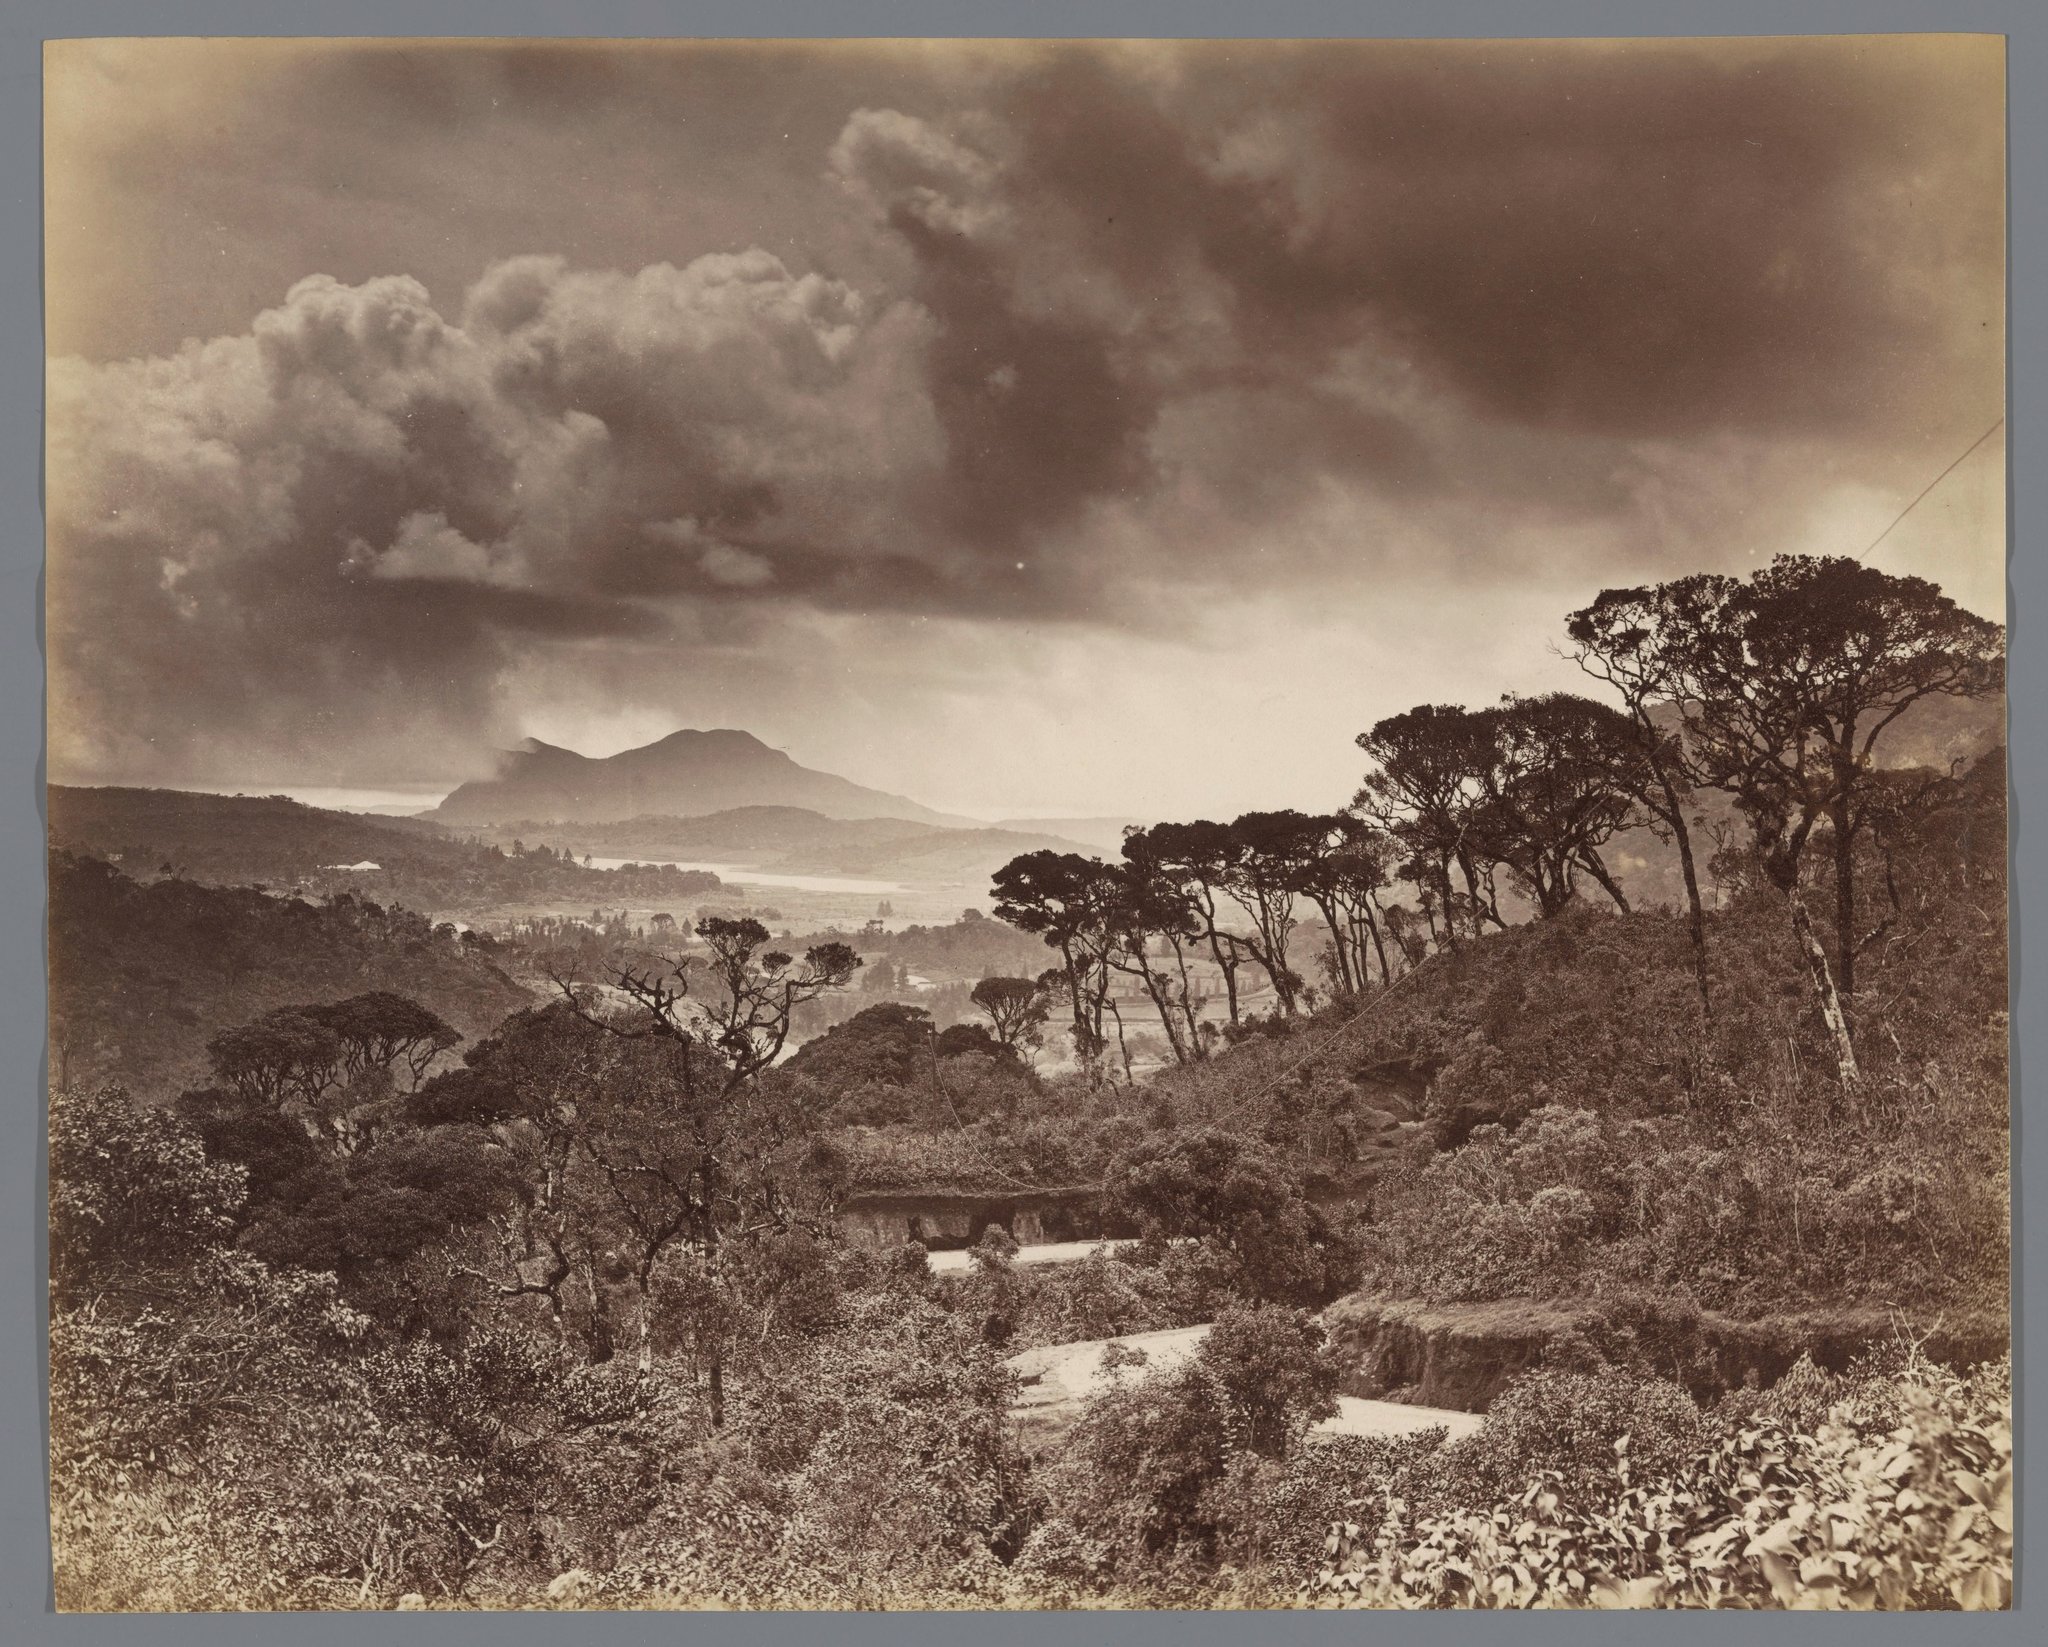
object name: photograph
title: View of Nuwara Eliya from the Ramboda pass, Sri Lanka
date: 1862-1903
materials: paper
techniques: albumen print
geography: sri lanka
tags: dale, valley, forest, wood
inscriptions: check stamp: ‘Photographers/ W.L.H. Skeen & Co/ Colombo, Ceylon’, title: ‘Newara Eliya from the top of the Rambodde Pass’